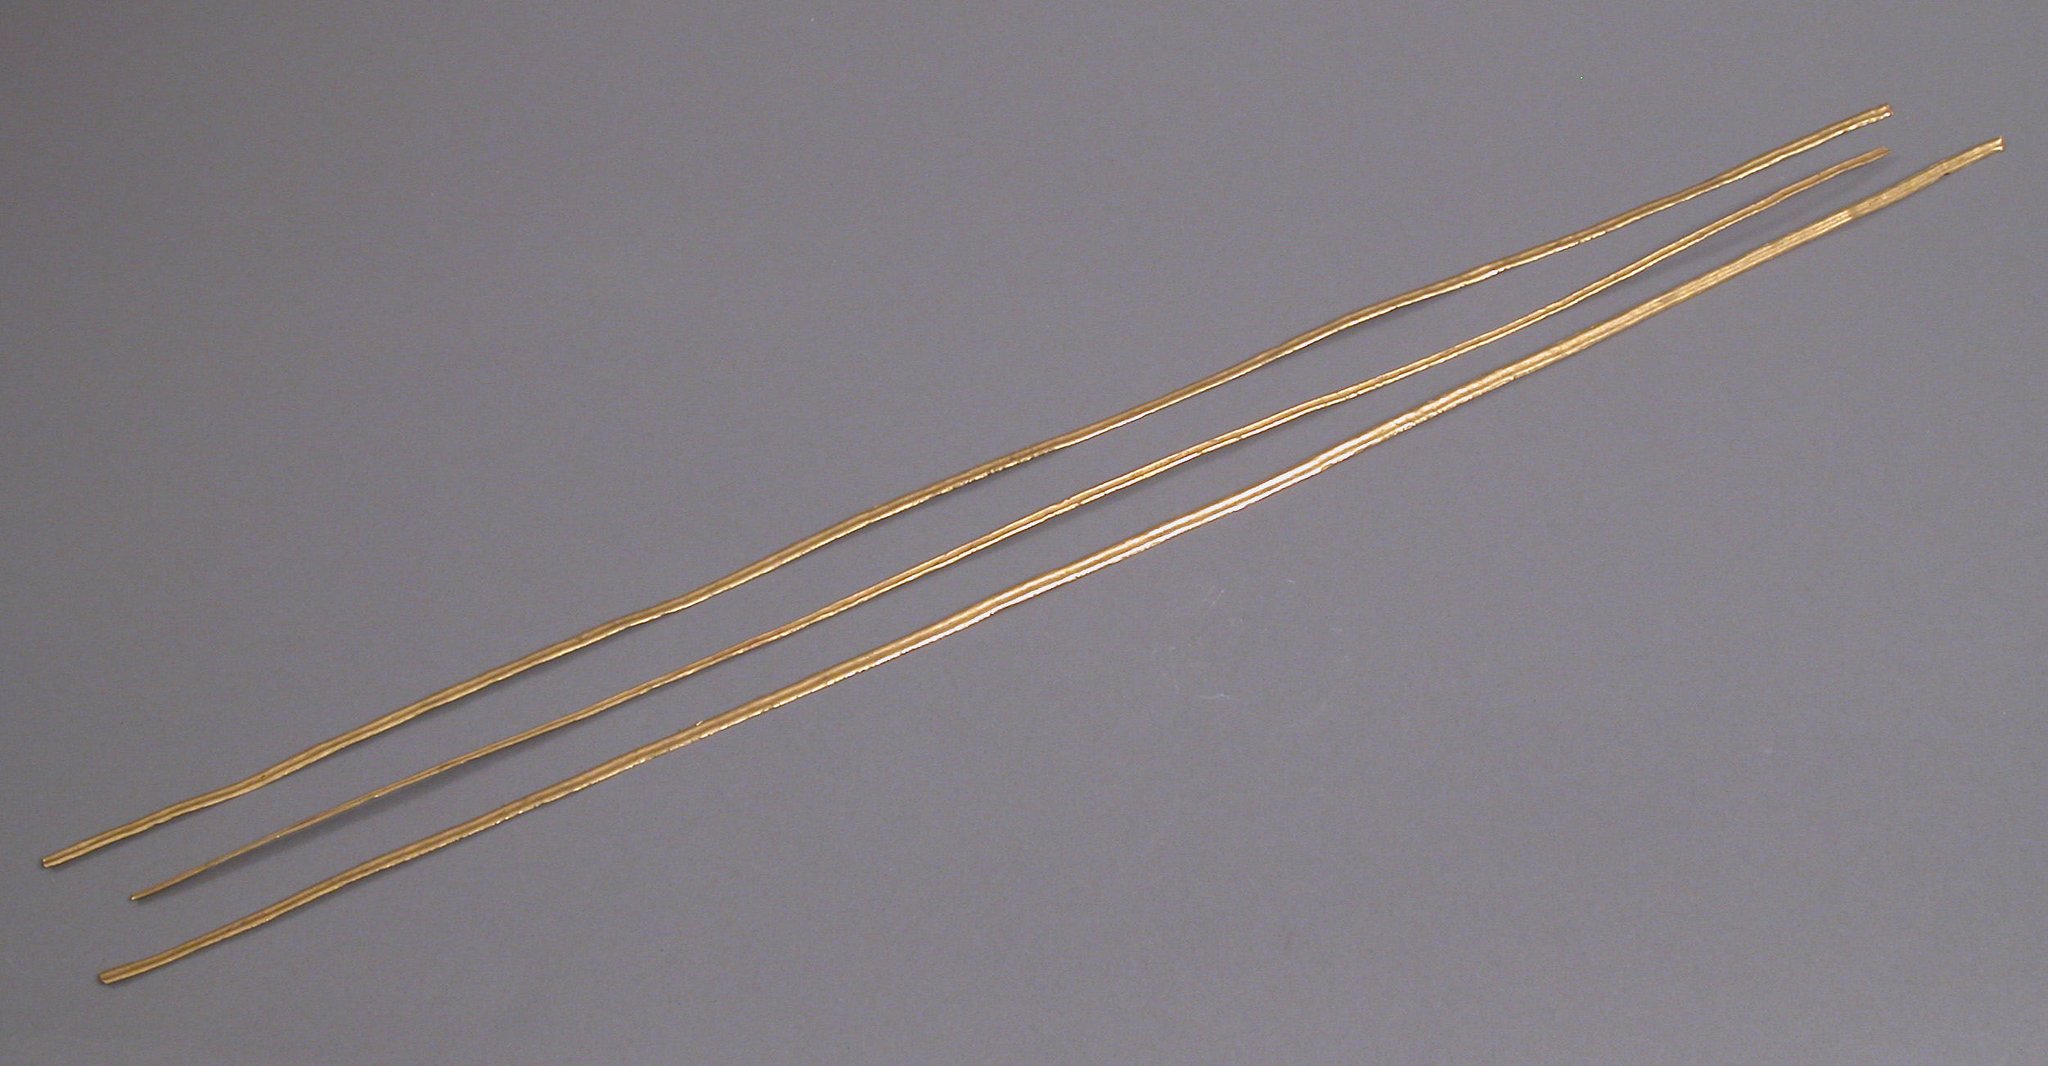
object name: lamella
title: Gold Strip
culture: avar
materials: gold